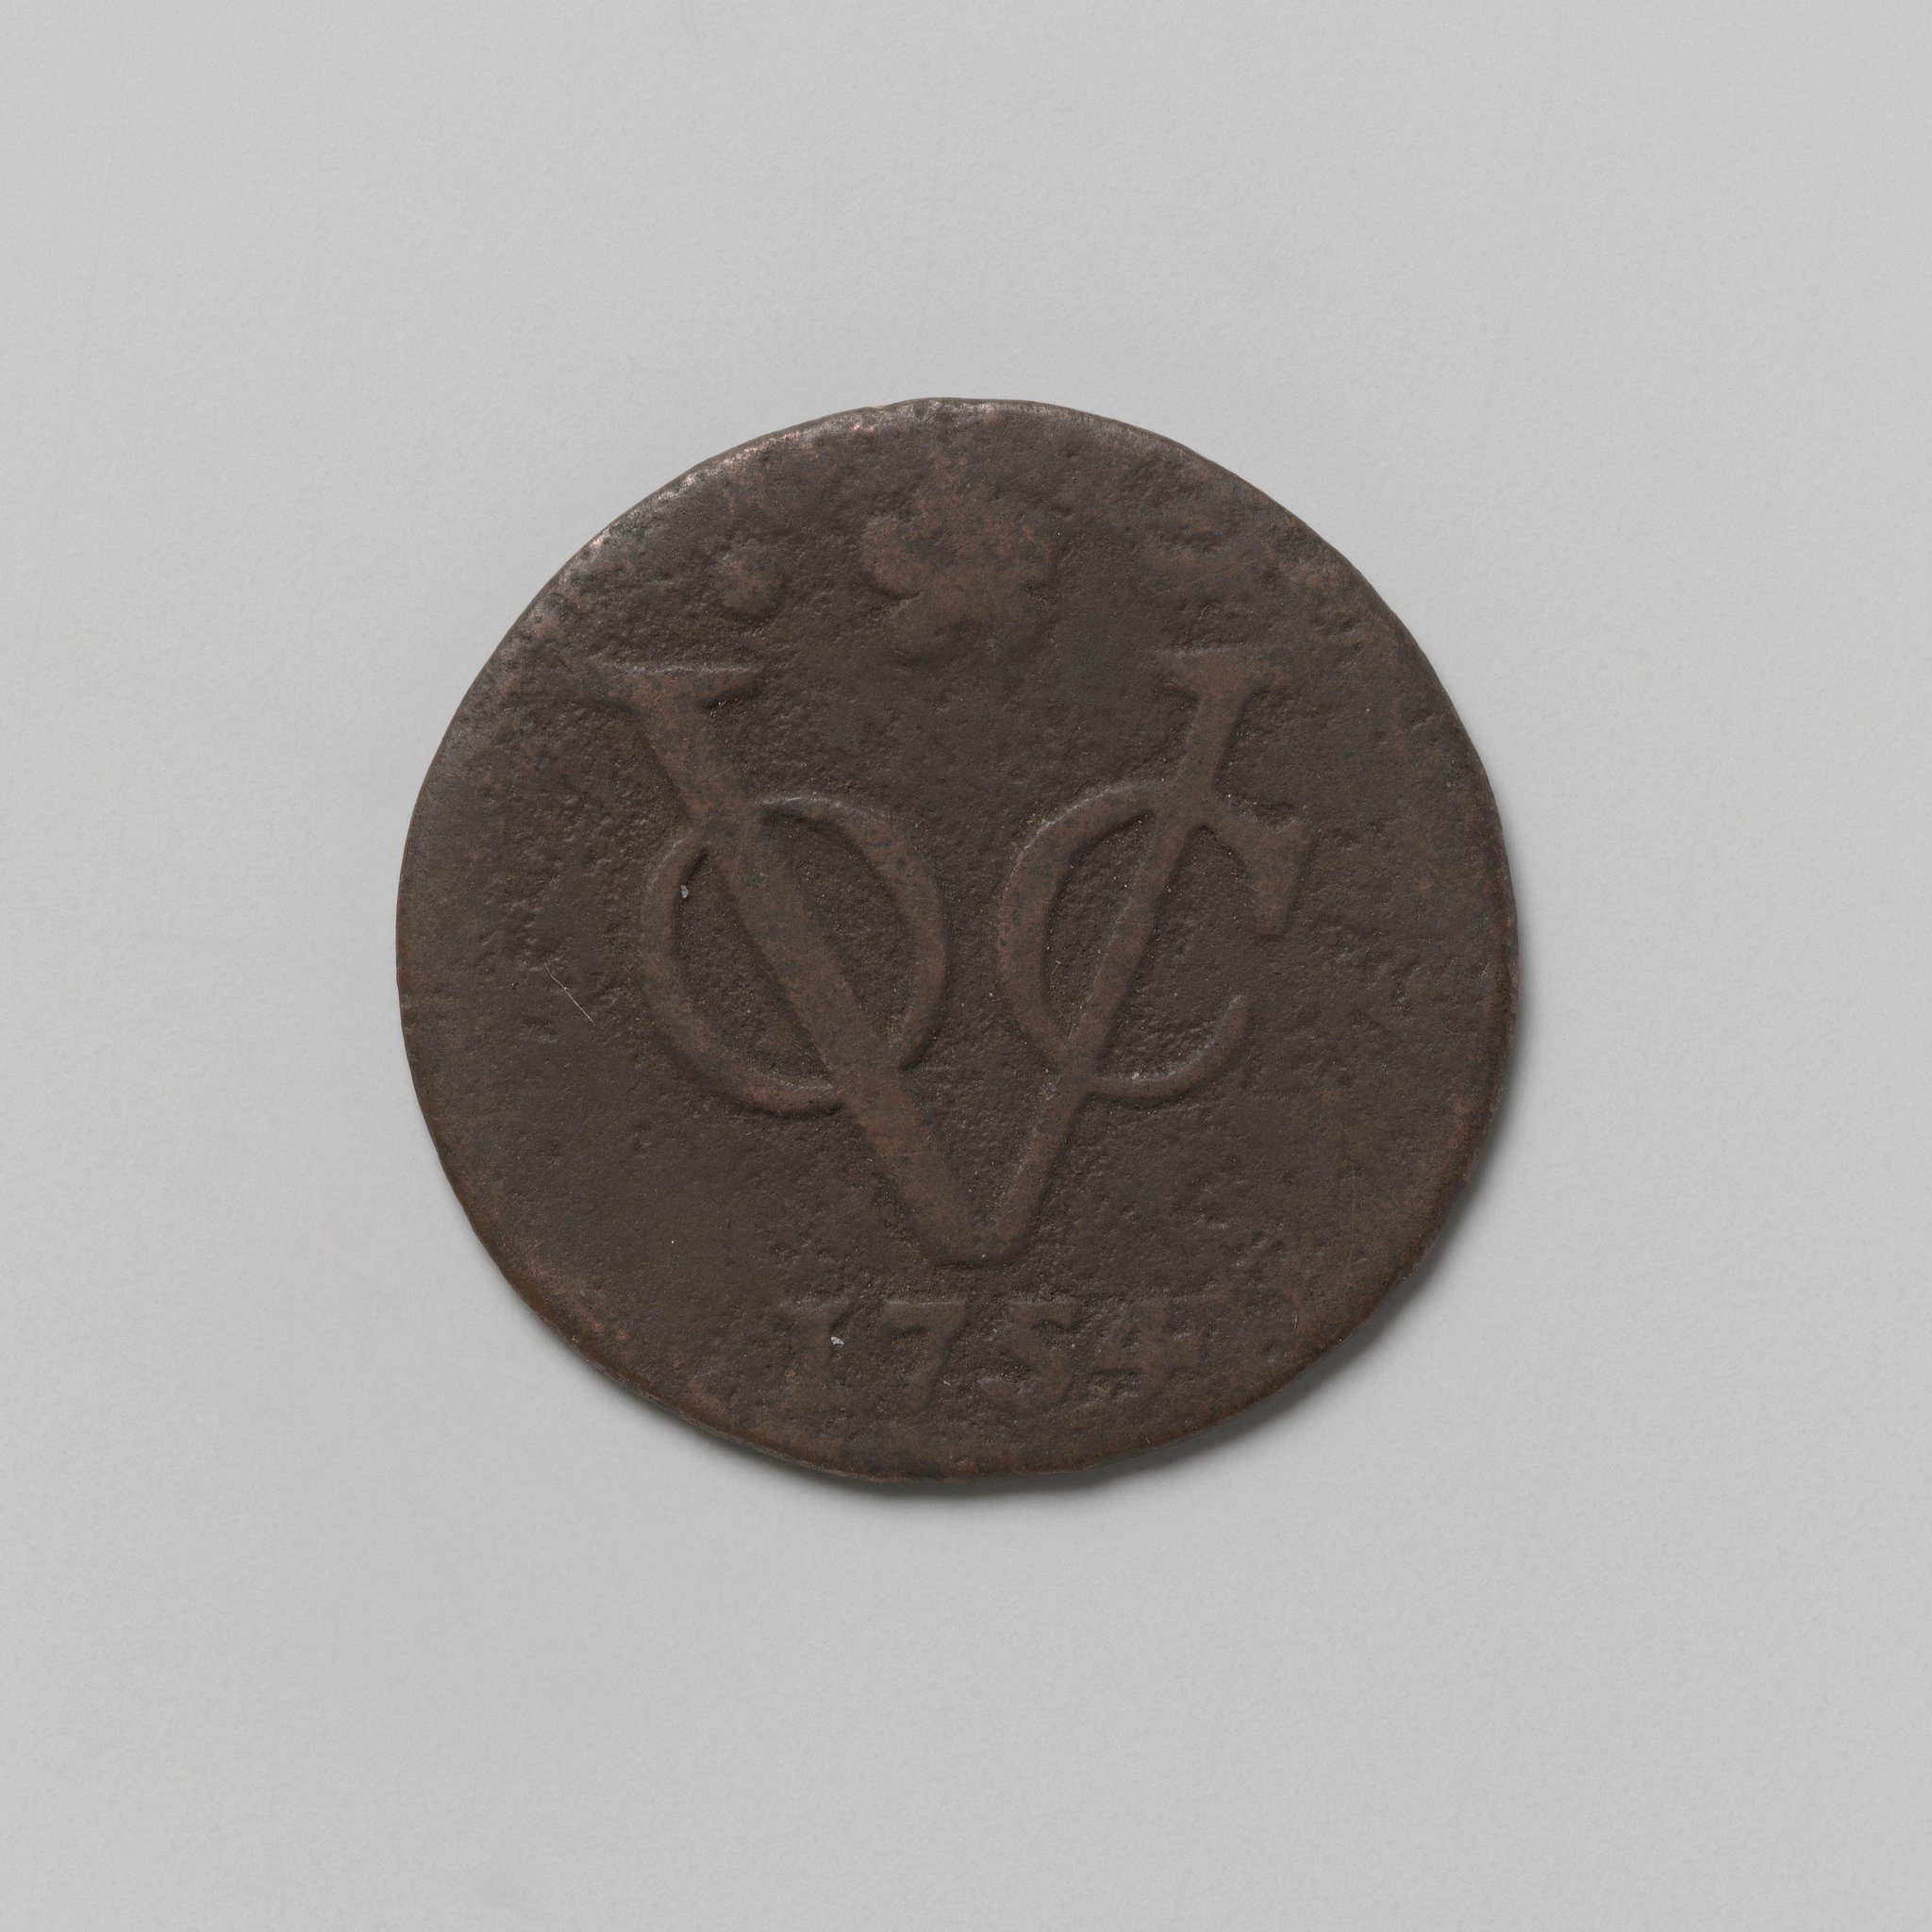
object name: coin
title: ½ duit van de VOC uit Holland, 1754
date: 1754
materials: copper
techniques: striking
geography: dordrecht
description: Koperen munt. Voorzijde: gekroond wapenschild van Holland. Keerzijde: monogram van de VOC, waarboven muntteken en waaronder jaartal. Gladde rand.